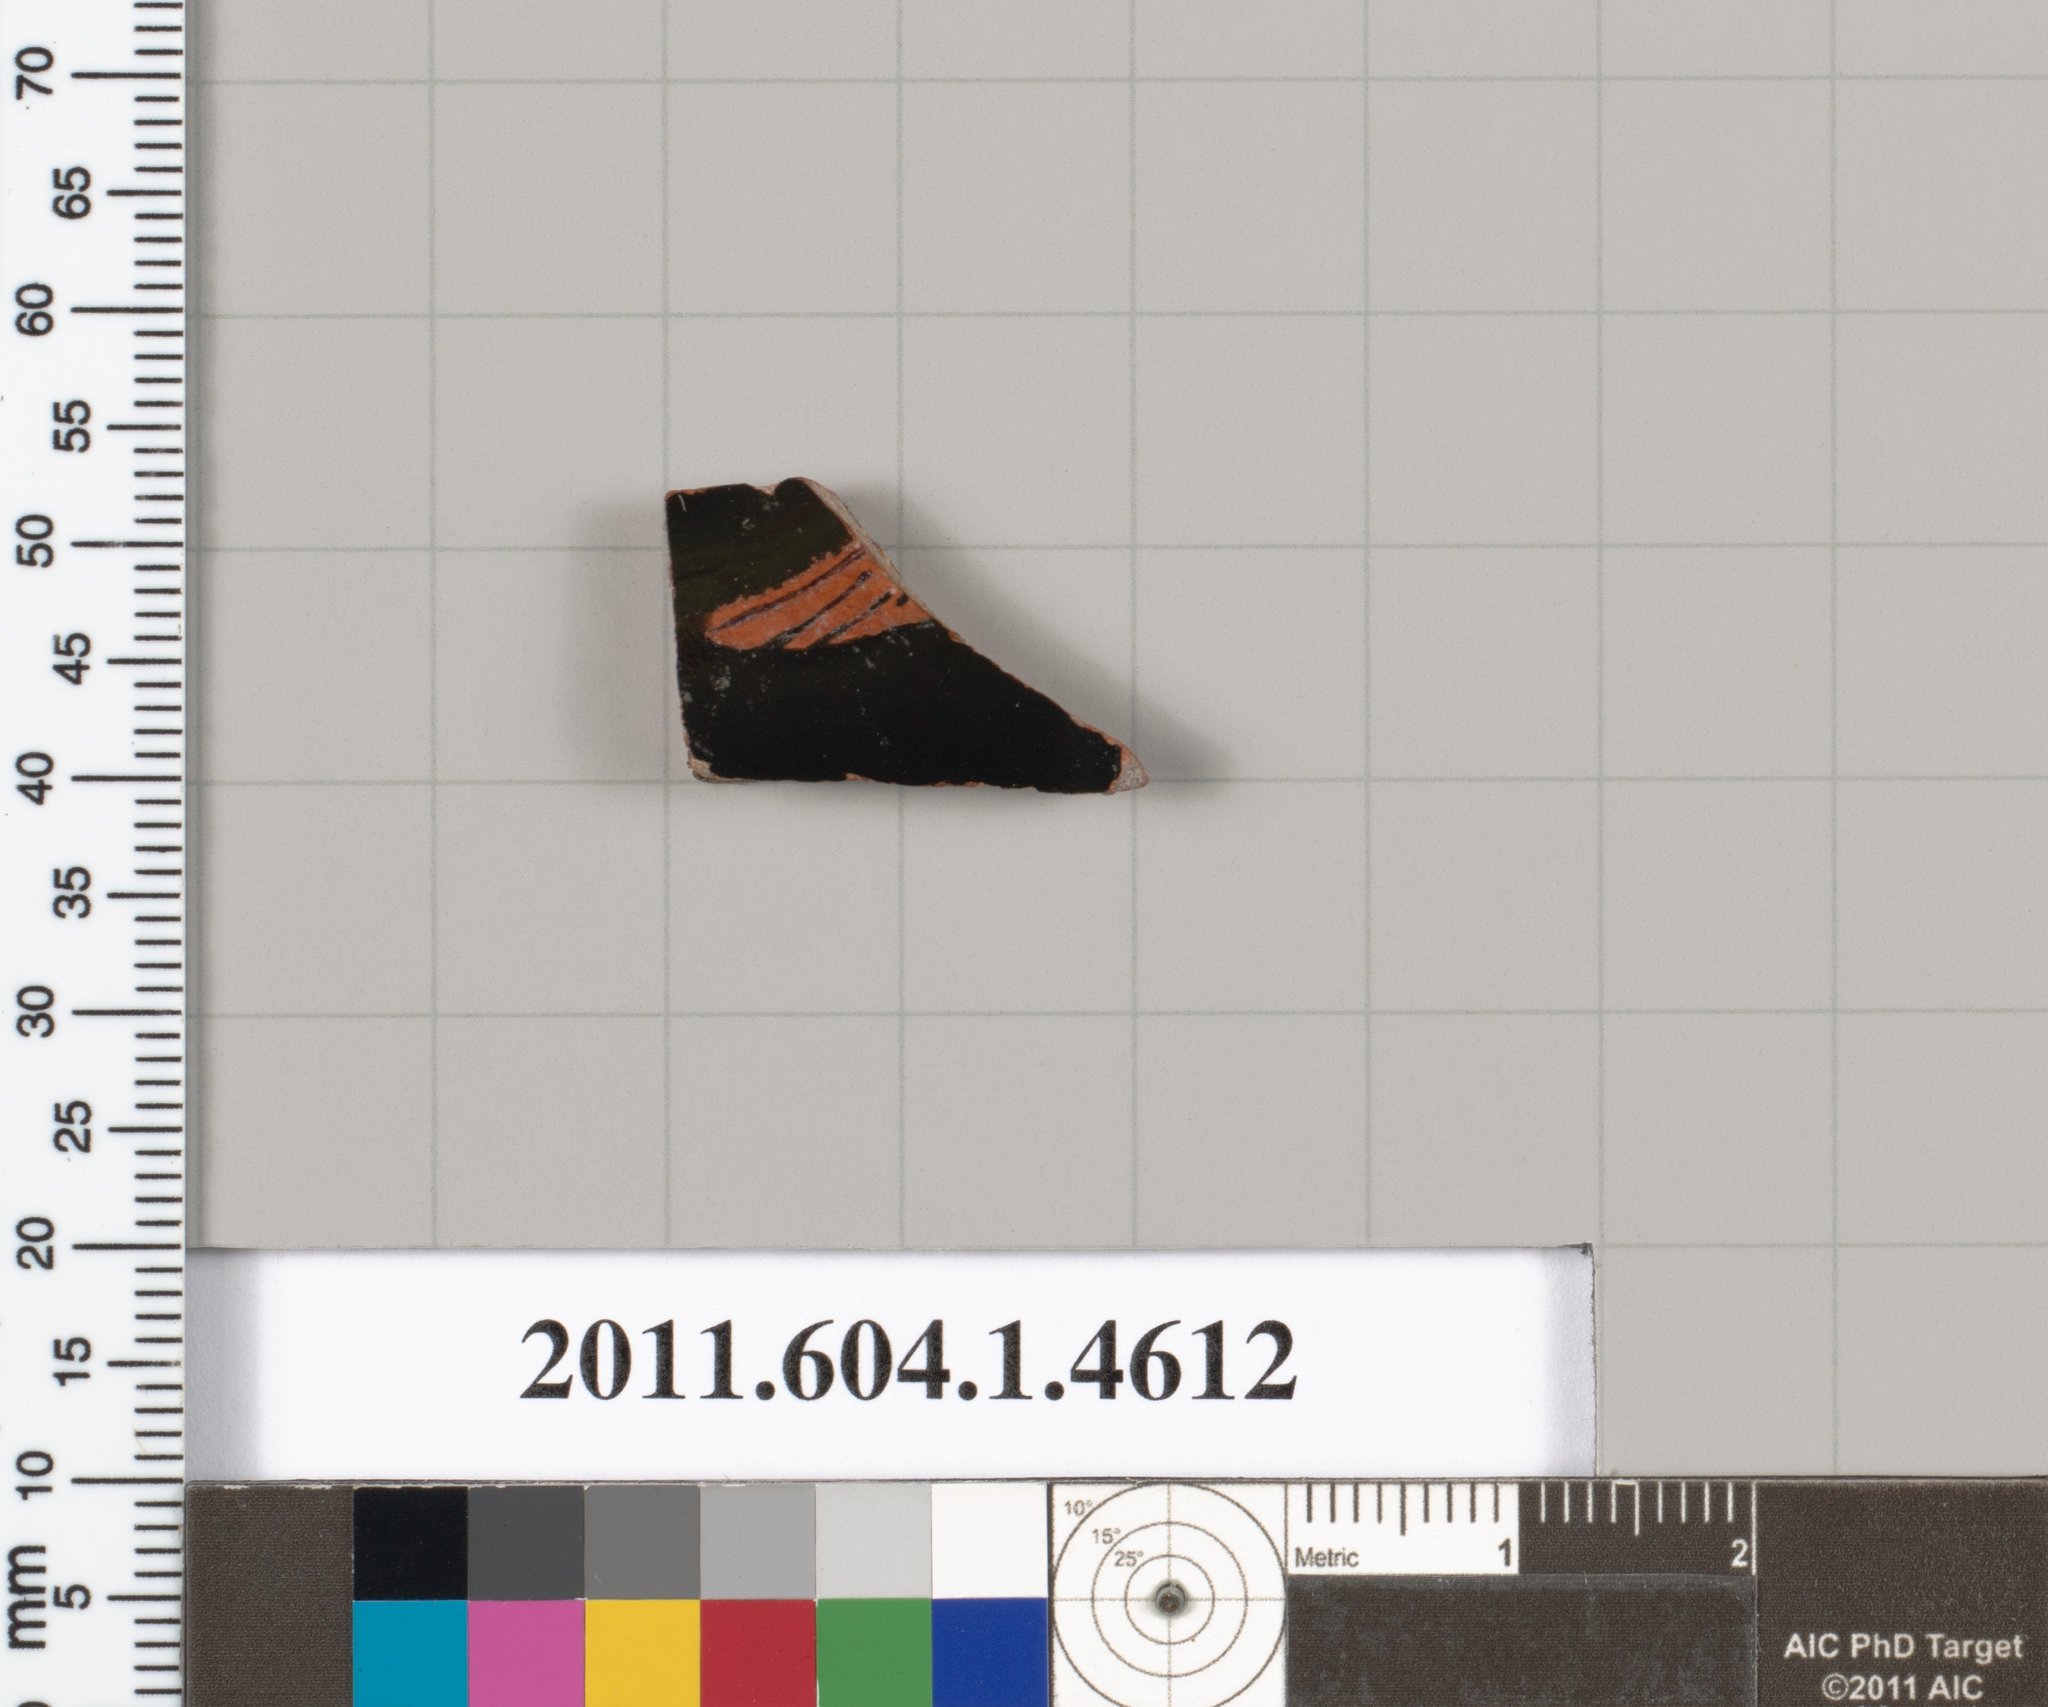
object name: kylix fragment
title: Terracotta fragment of a kylix (drinking cup)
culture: greek, attic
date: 490-470 BCE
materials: terracotta